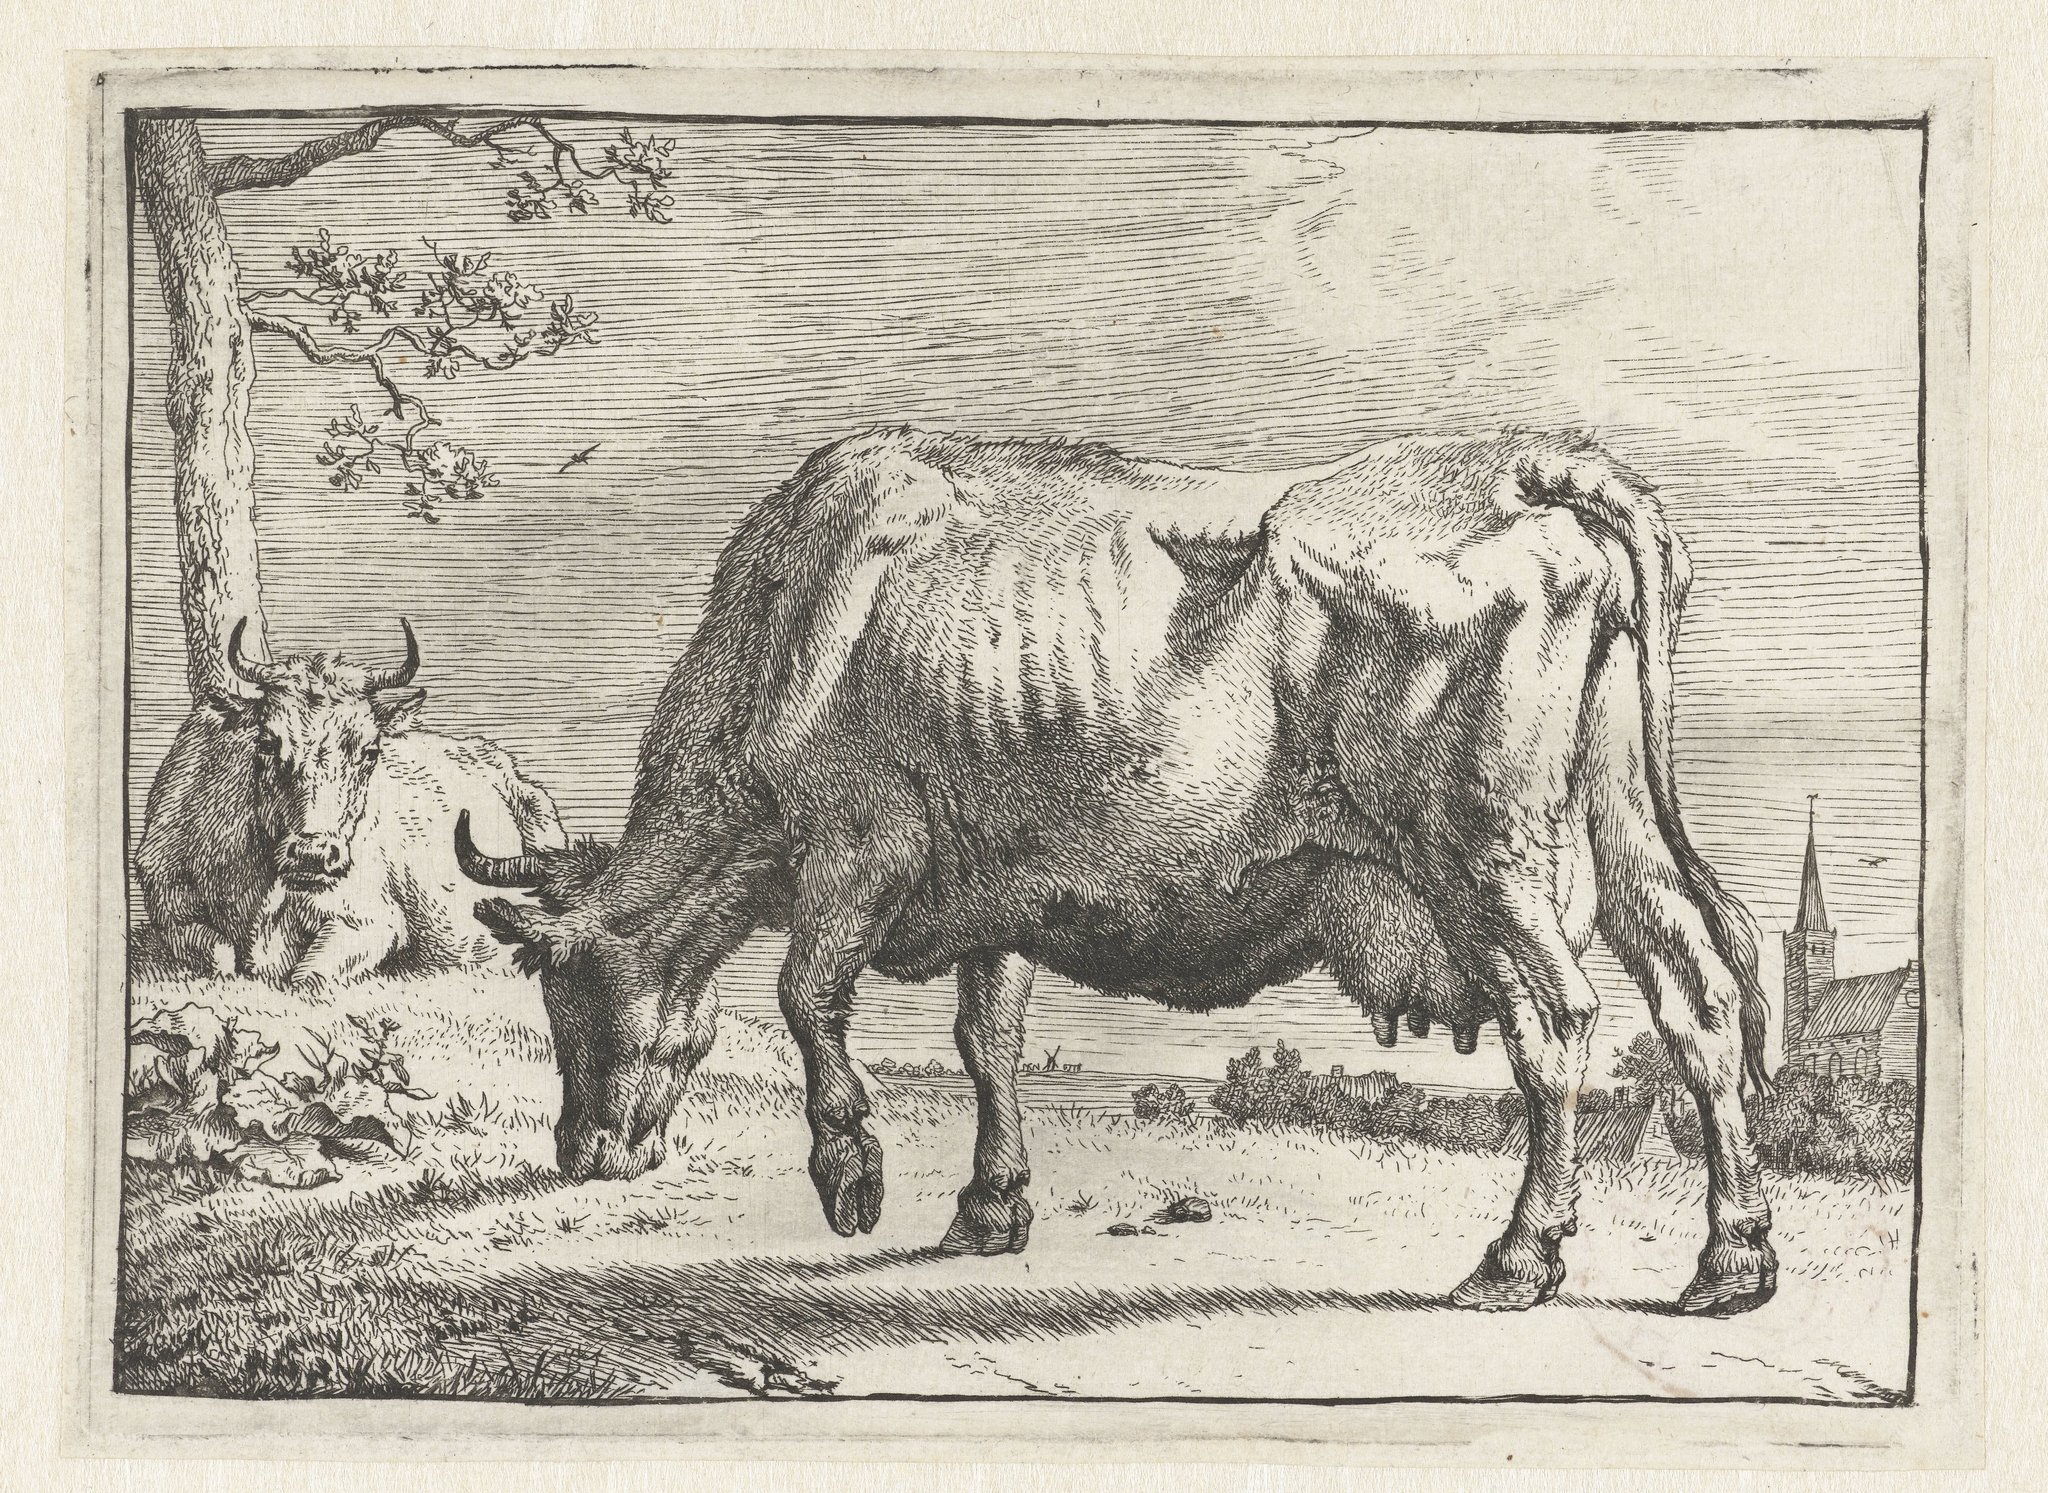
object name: print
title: Het Bullenboekje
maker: paulus potter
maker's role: draughtsman, painter, print maker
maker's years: 1625-1654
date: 1650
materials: paper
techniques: etching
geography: netherlands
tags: cow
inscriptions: collector's mark: Lugt 240